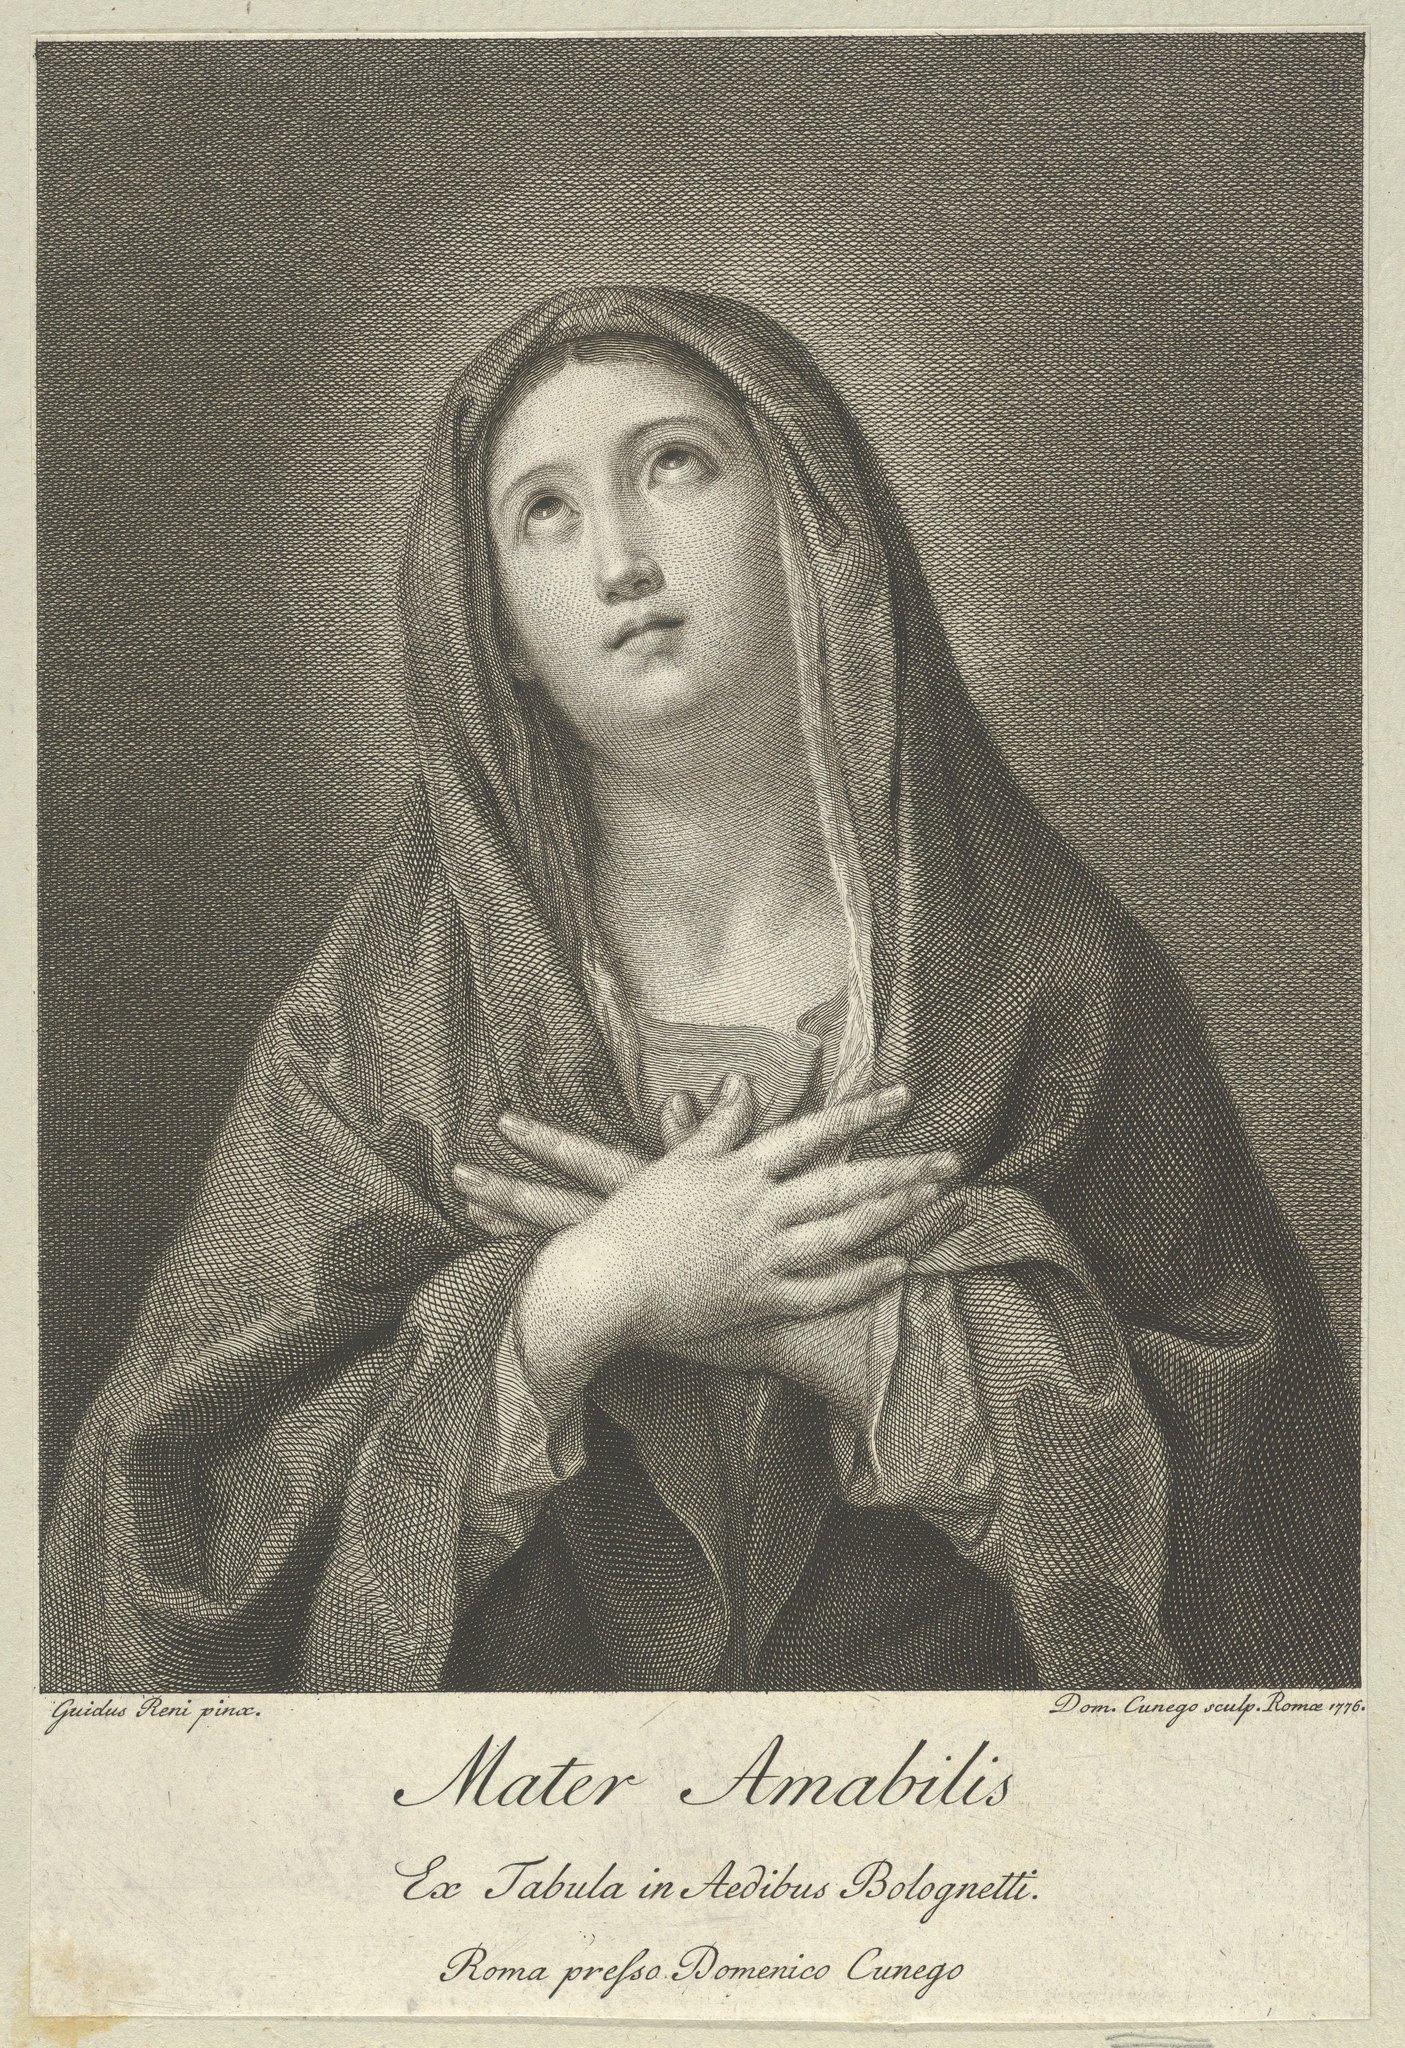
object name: print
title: The Virgin looking upwards with hands crossed over her chest, after Reni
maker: domenico cunego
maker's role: engraver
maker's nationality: italian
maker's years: 1727-1803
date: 1776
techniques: engraving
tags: virgin mary